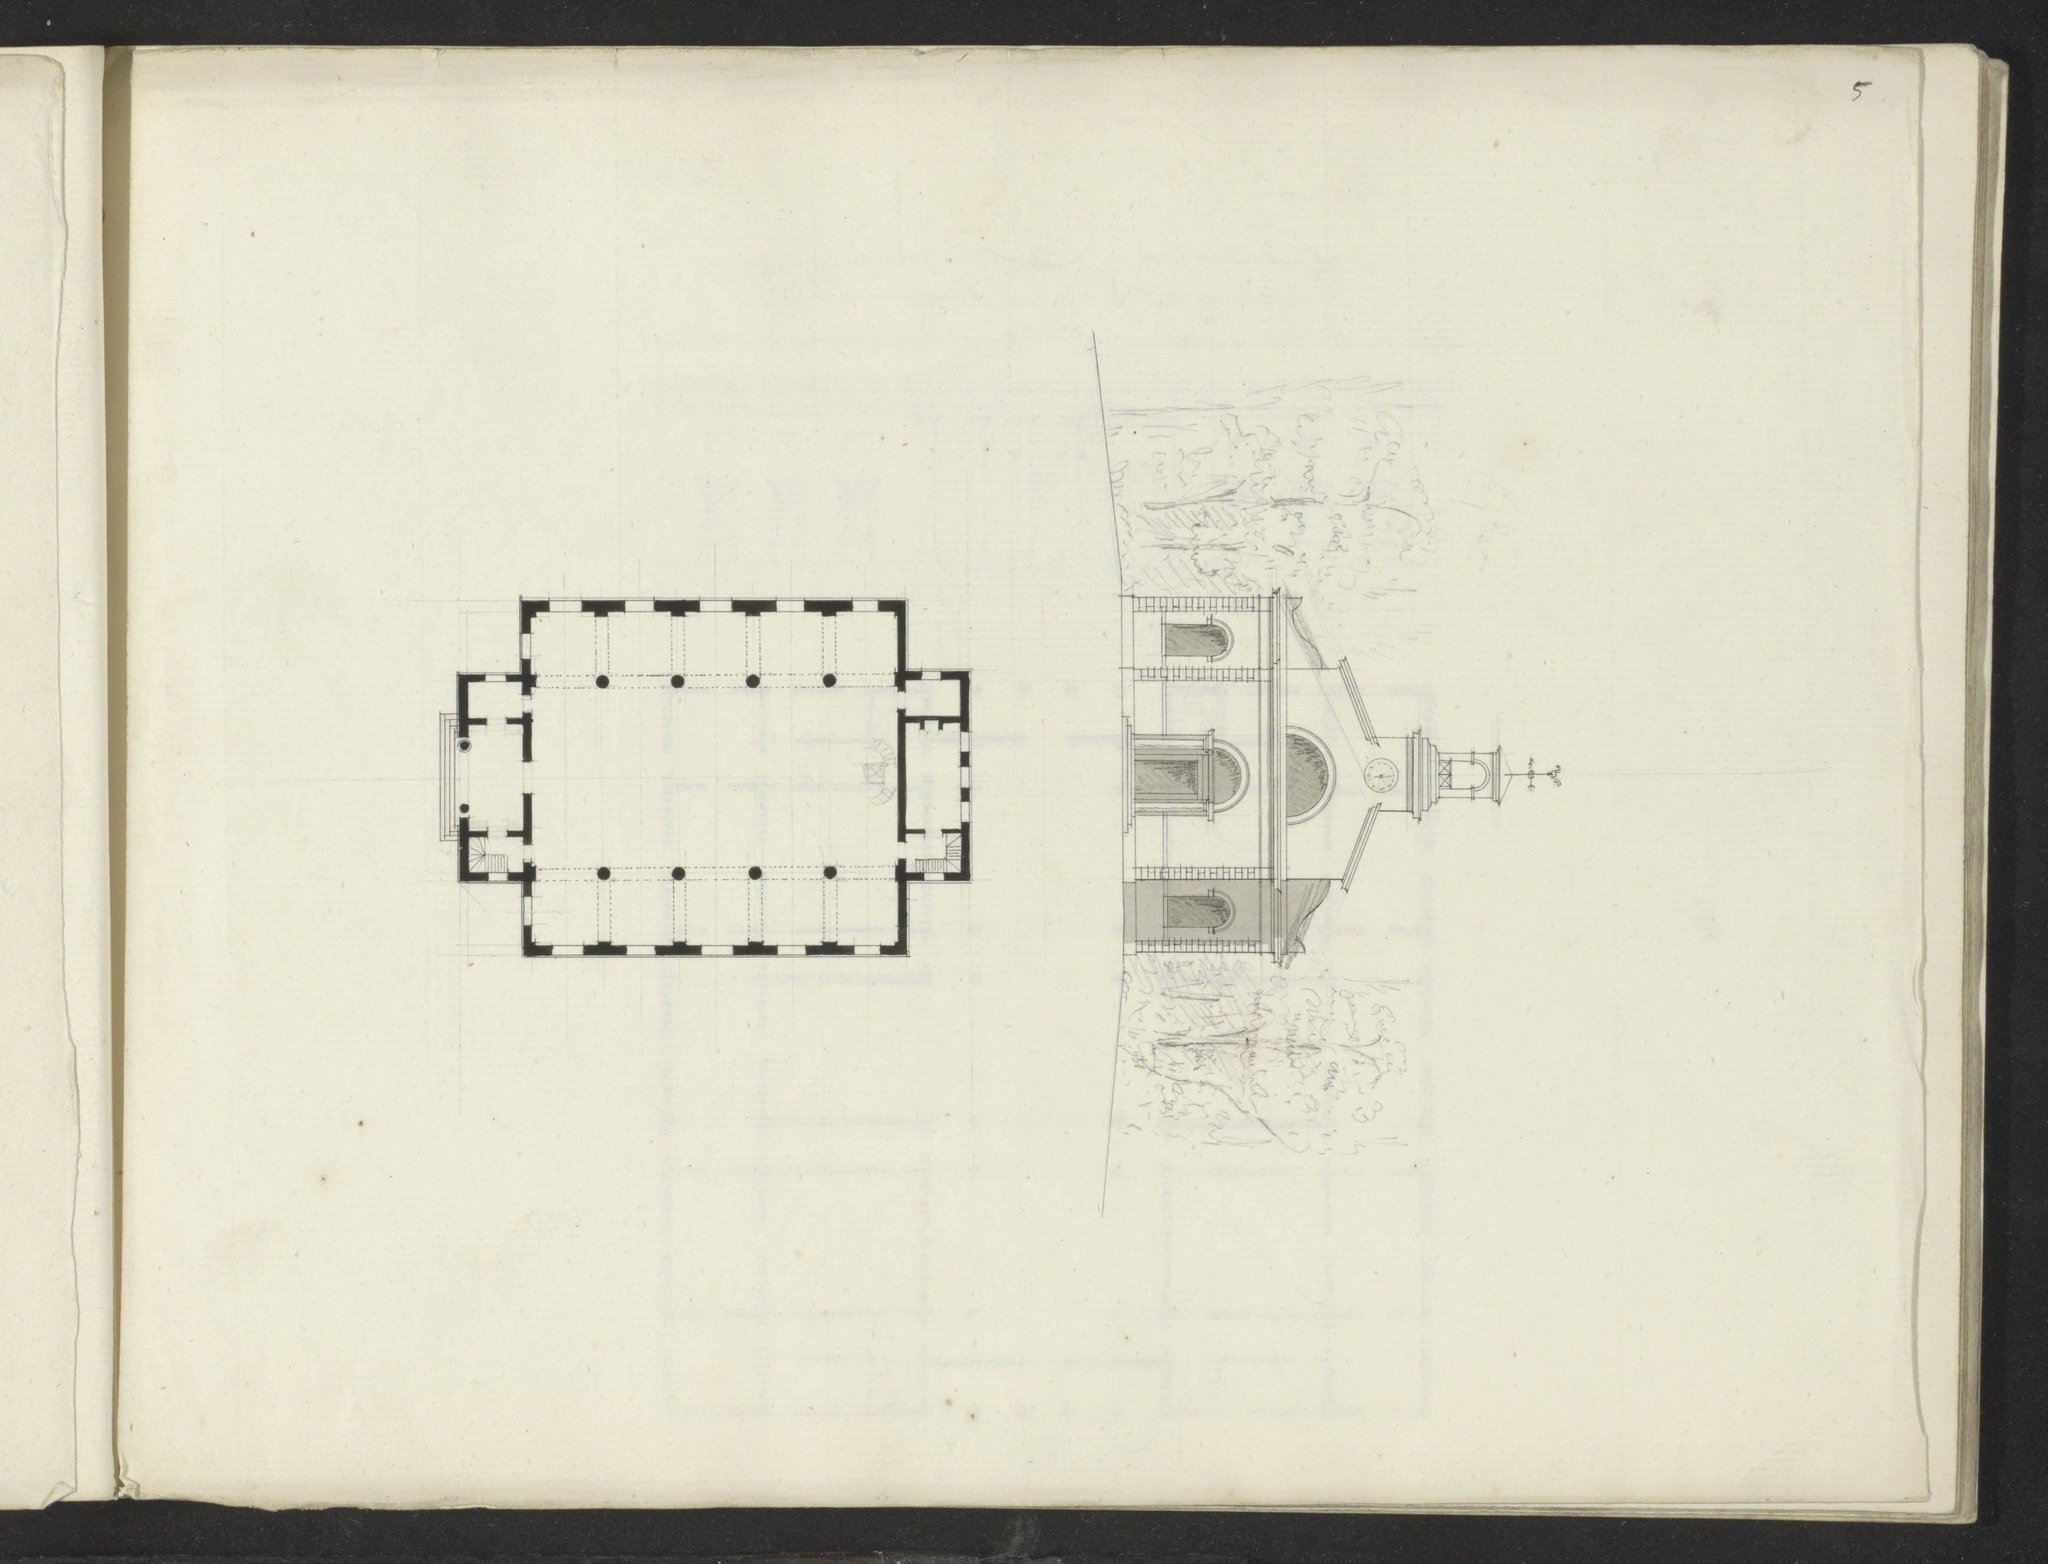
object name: sketchbook leaf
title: Plattegrond en voorgevel van een vrijstaand gebouw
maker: willem springer jr.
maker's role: draughtsman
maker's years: 1815-1907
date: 1825-1907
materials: ink, paper, pencil, watercolor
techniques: brush, pen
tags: façade (of house or building), plan ~ architecture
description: Pagina 5 uit een schetsboek met 28 pagina's.